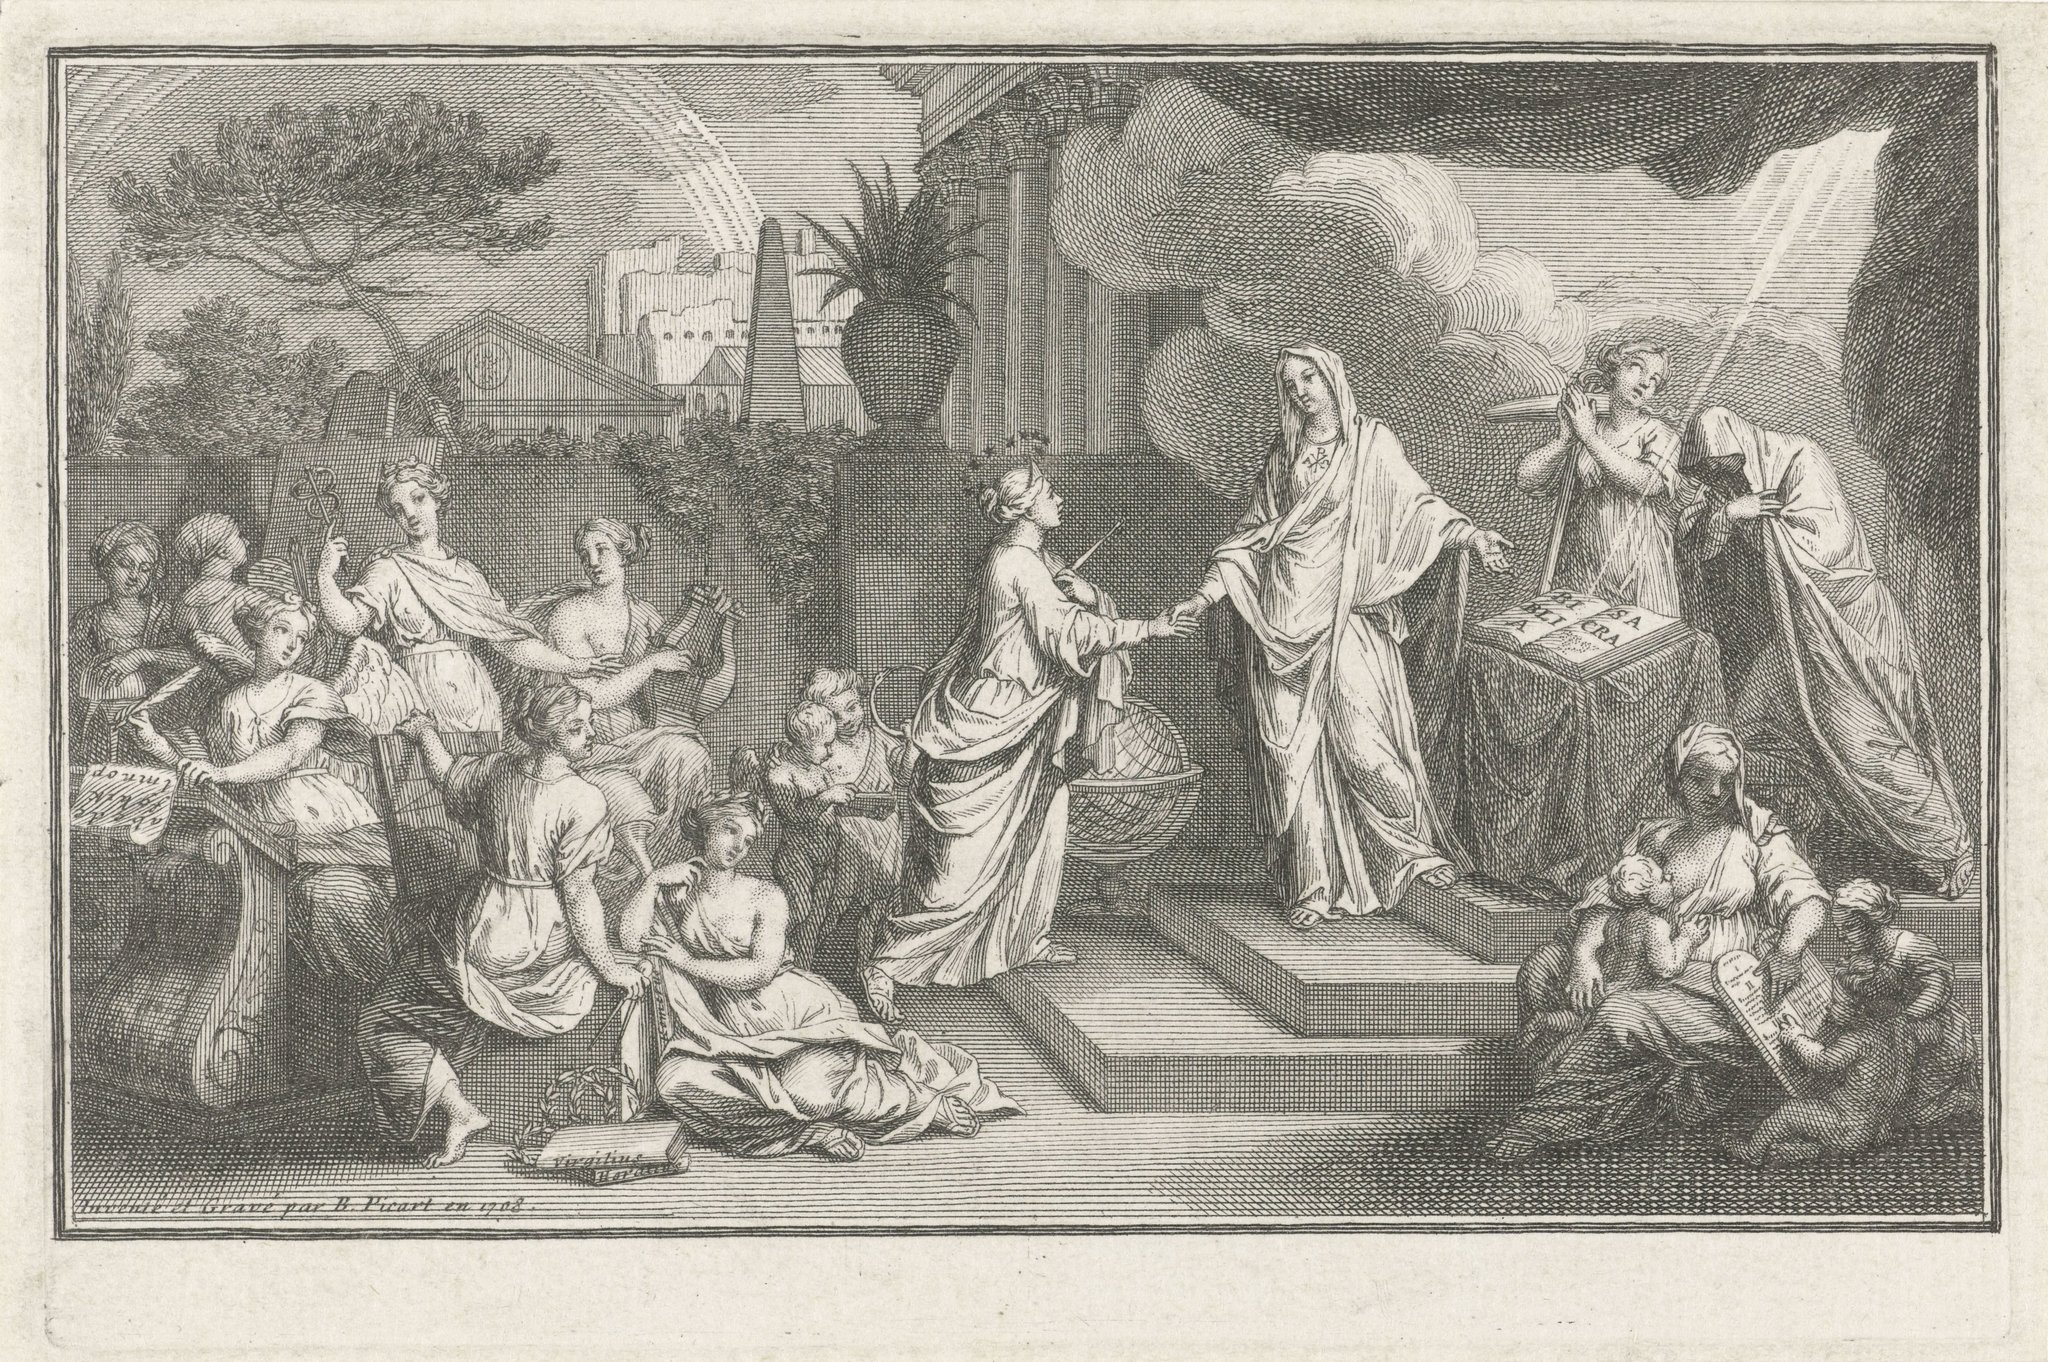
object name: print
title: Allegorische voorstelling van de overeenkomst tussen religie en filosofie, of het geloof en de rede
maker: bernard picart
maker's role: draughtsman, print maker, publisher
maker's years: 1673-1733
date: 1708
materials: paper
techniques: engraving, etching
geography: paris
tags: charity, 'caritas'; 'carità' (ripa) ~ one of the three theological virtues, faith, 'fides'; 'fede', 'fede catholica', 'fede christiana', 'fede christiana catholica' (ripa) ~ one of the three theological virtues, hope, 'spes'; 'speranza divina e certa' (ripa) ~ one of the three theological virtues, reason; 'ragione' (ripa) (+ symbolical representation of concept), the liberal arts together with other disciplines, 'philosophia'; 'filosofia' (ripa), allegorical and symbolical representations ~ the church and religion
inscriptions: collector's mark: Lugt 2228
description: De gepersonifieerde Filosofie, met een krans van sterren boven het hoofd, schudt de hand van Religie, die op de bijbel wijst. Achter hen staan Hoop (Spes) en Geloof (Fides). Rechts op de voorgrond Liefde (Caritas) die kinderen wijst op de tafelen der wet. Links de vrouwlijke personificaties van de zeven vrije kunsten. Met een lege marge.